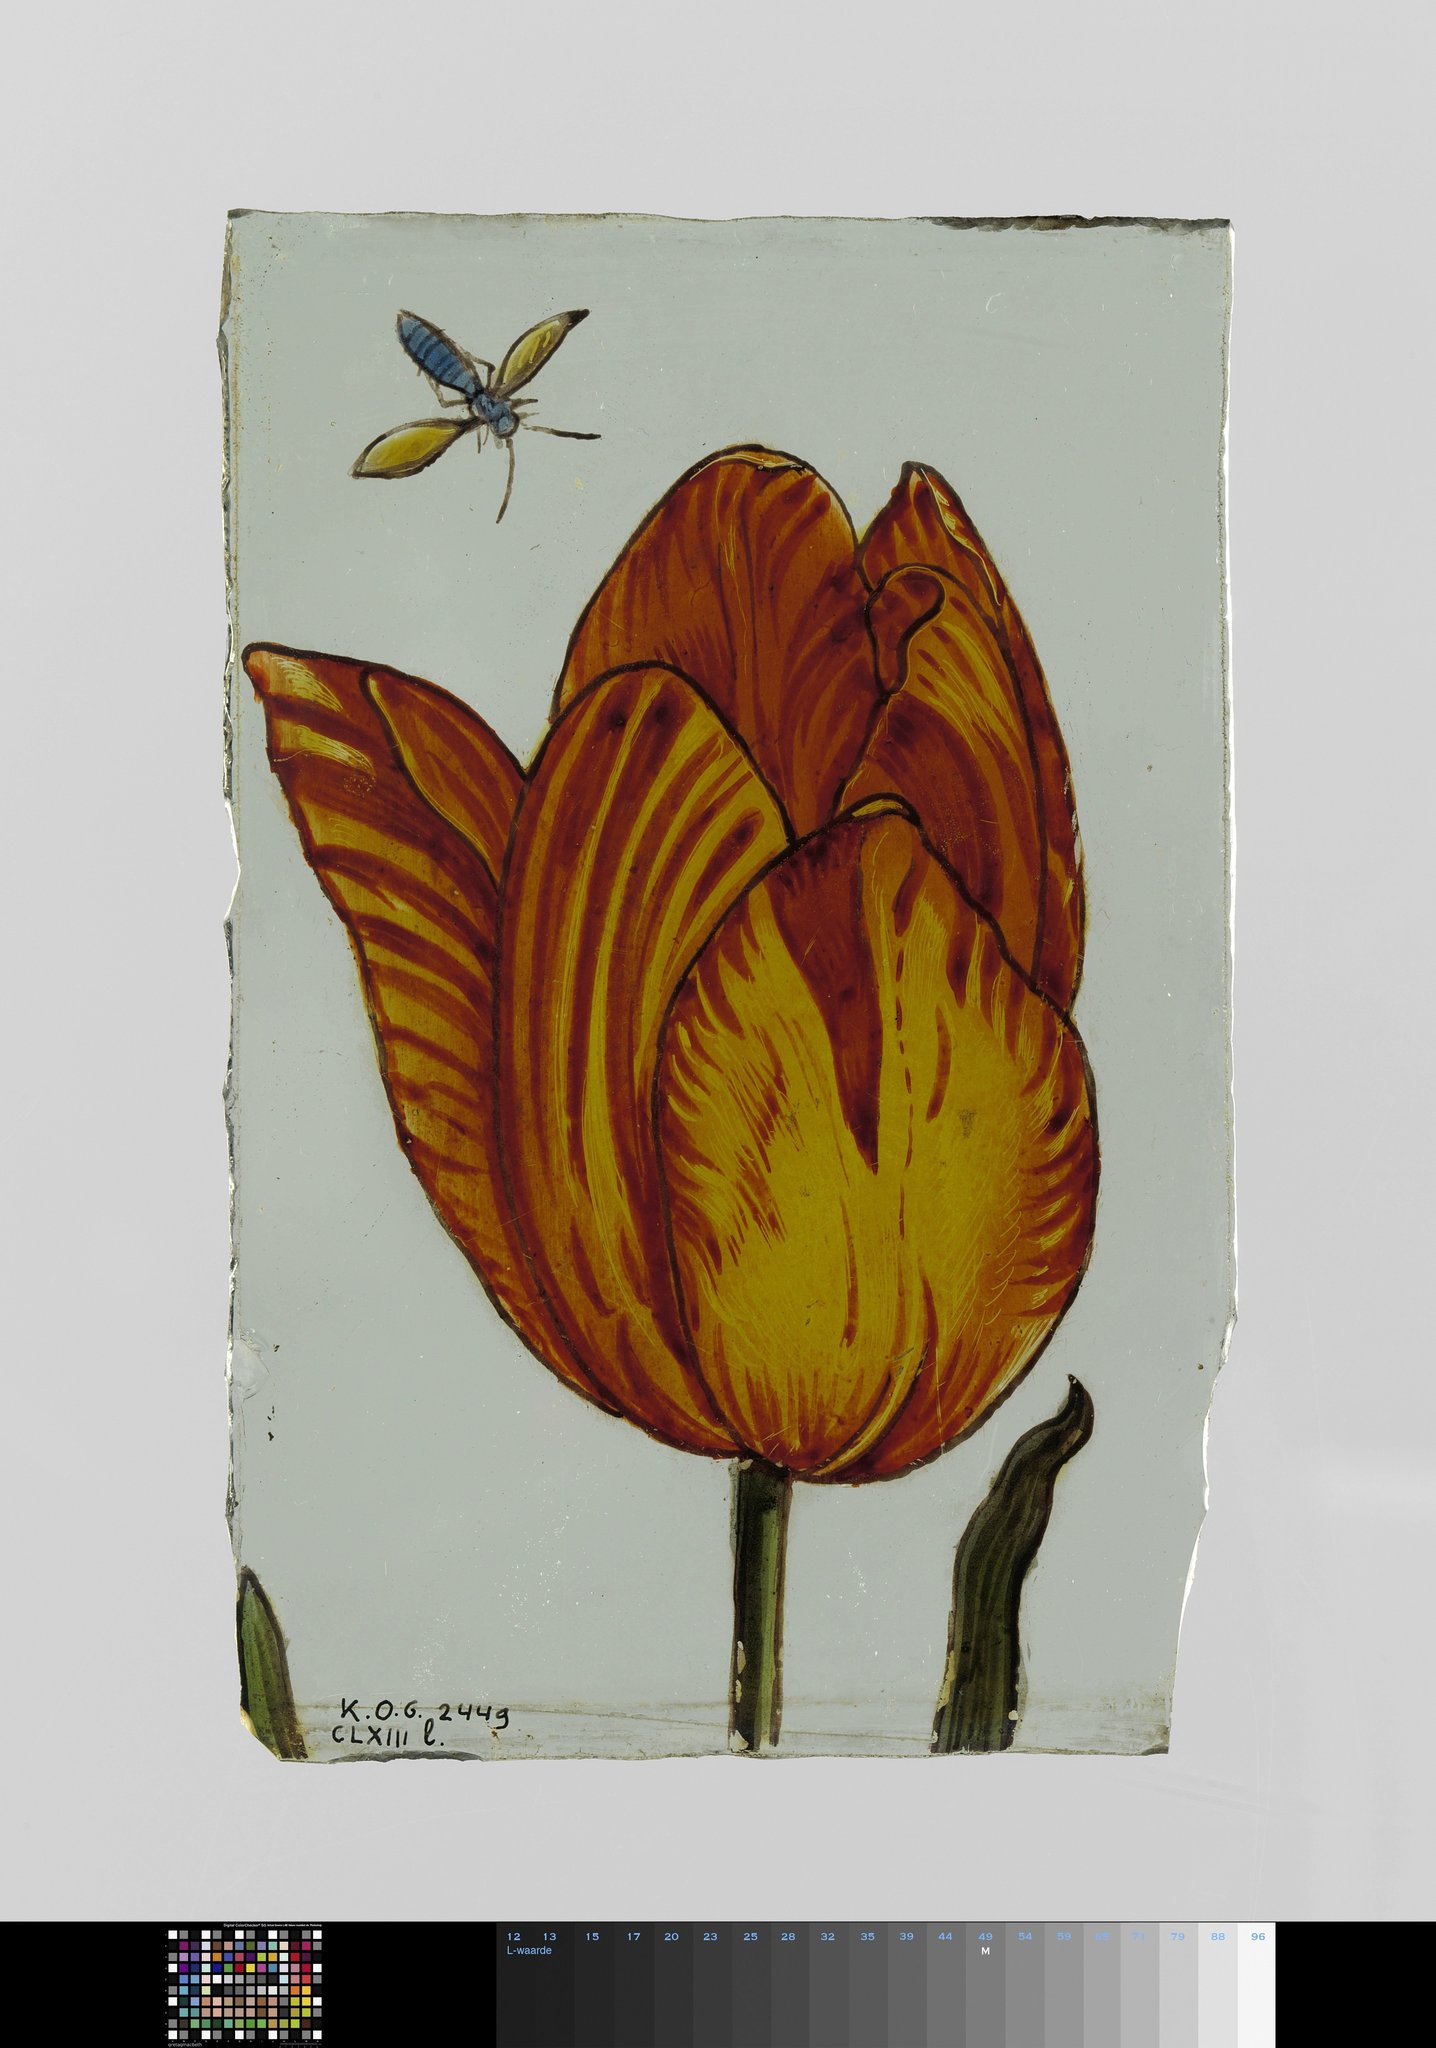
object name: light window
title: Glass with a Tulip and Insect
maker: Anonymous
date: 1550-1600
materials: glass, lead, pigment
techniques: leading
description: Ruitje met emailschildering van een tulp en een insekt in overwegend geel, rood en oranje. Opmerking: Onderdeel van de groep BK-CLXIII-a t/m r.